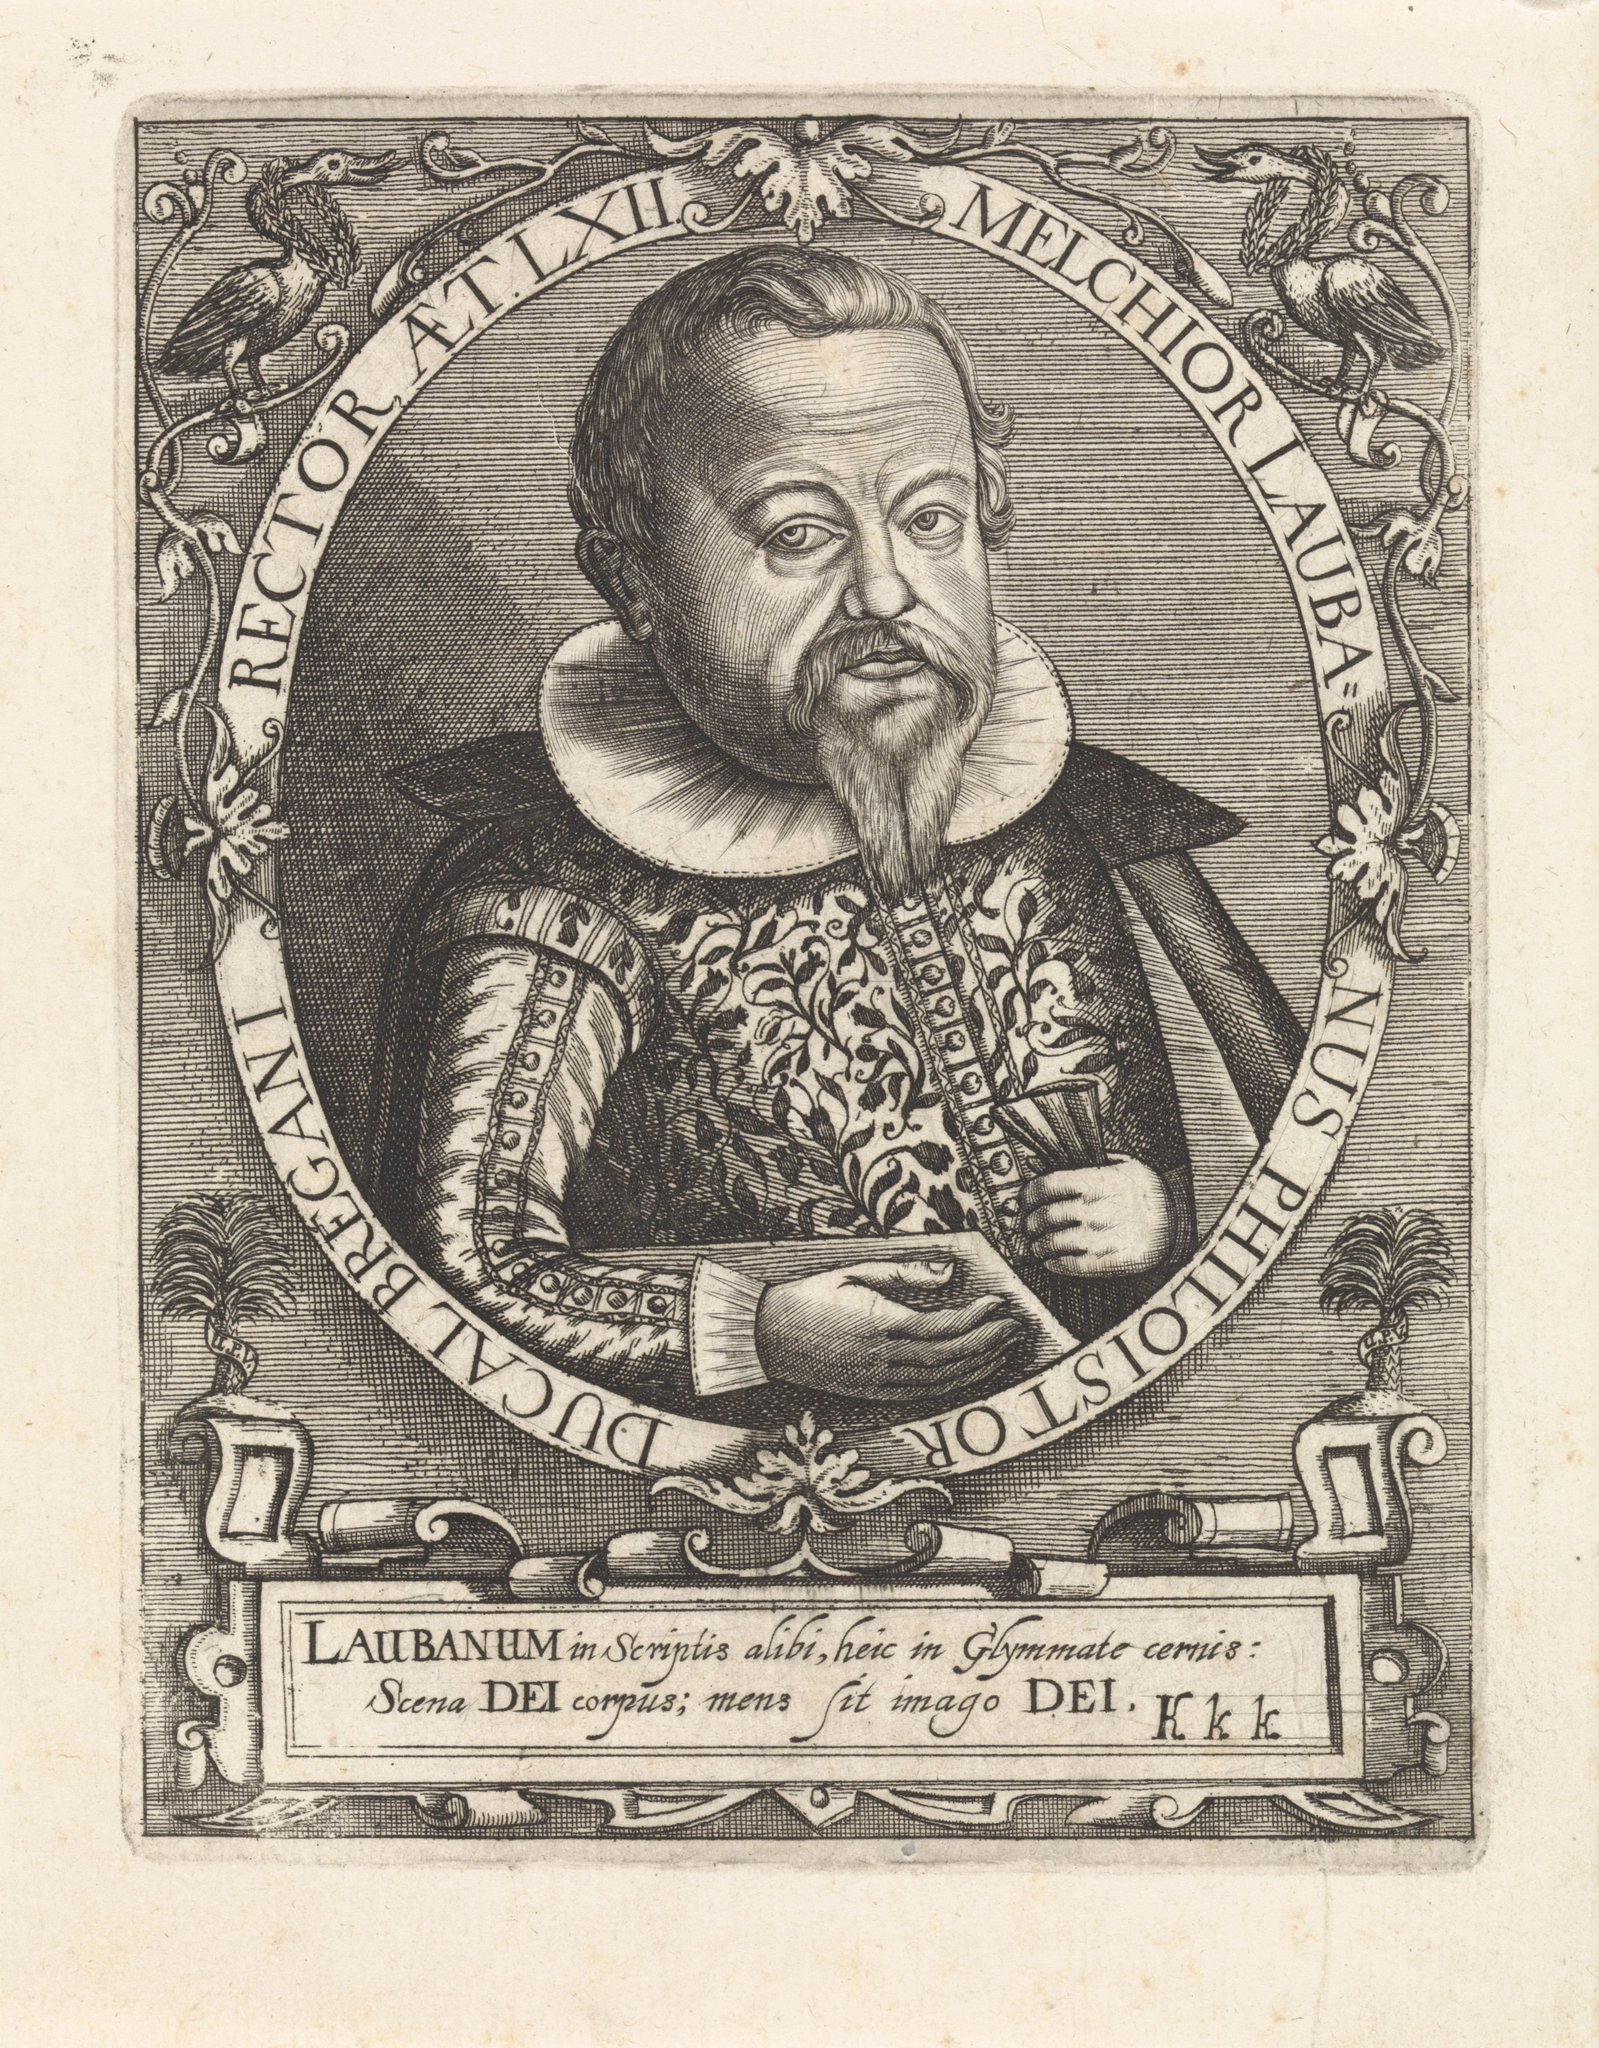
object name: book illustration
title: Portretten van beroemde Europese wetenschappers, humanisten en geestelijken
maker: paul de zetter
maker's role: print maker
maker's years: 1600-1667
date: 1650-1669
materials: paper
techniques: engraving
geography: germany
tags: schlesien, schrijver, melchior laubanus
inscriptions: collector's mark: Lugt 2228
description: Prent gebruikt in een van de edities van Jean-Jacques Boissard. Boissard, Jean-Jacques. Bibliotheca sive Thesaurus Virtutis et Gloriae: In quo continentus Illvstrivm Ervditione & doctrina Virorum Effigies & Vitae (...). Frankfurt, [1628]. Zie Hollstein Dutch, deel LVIII, p. 86-87.